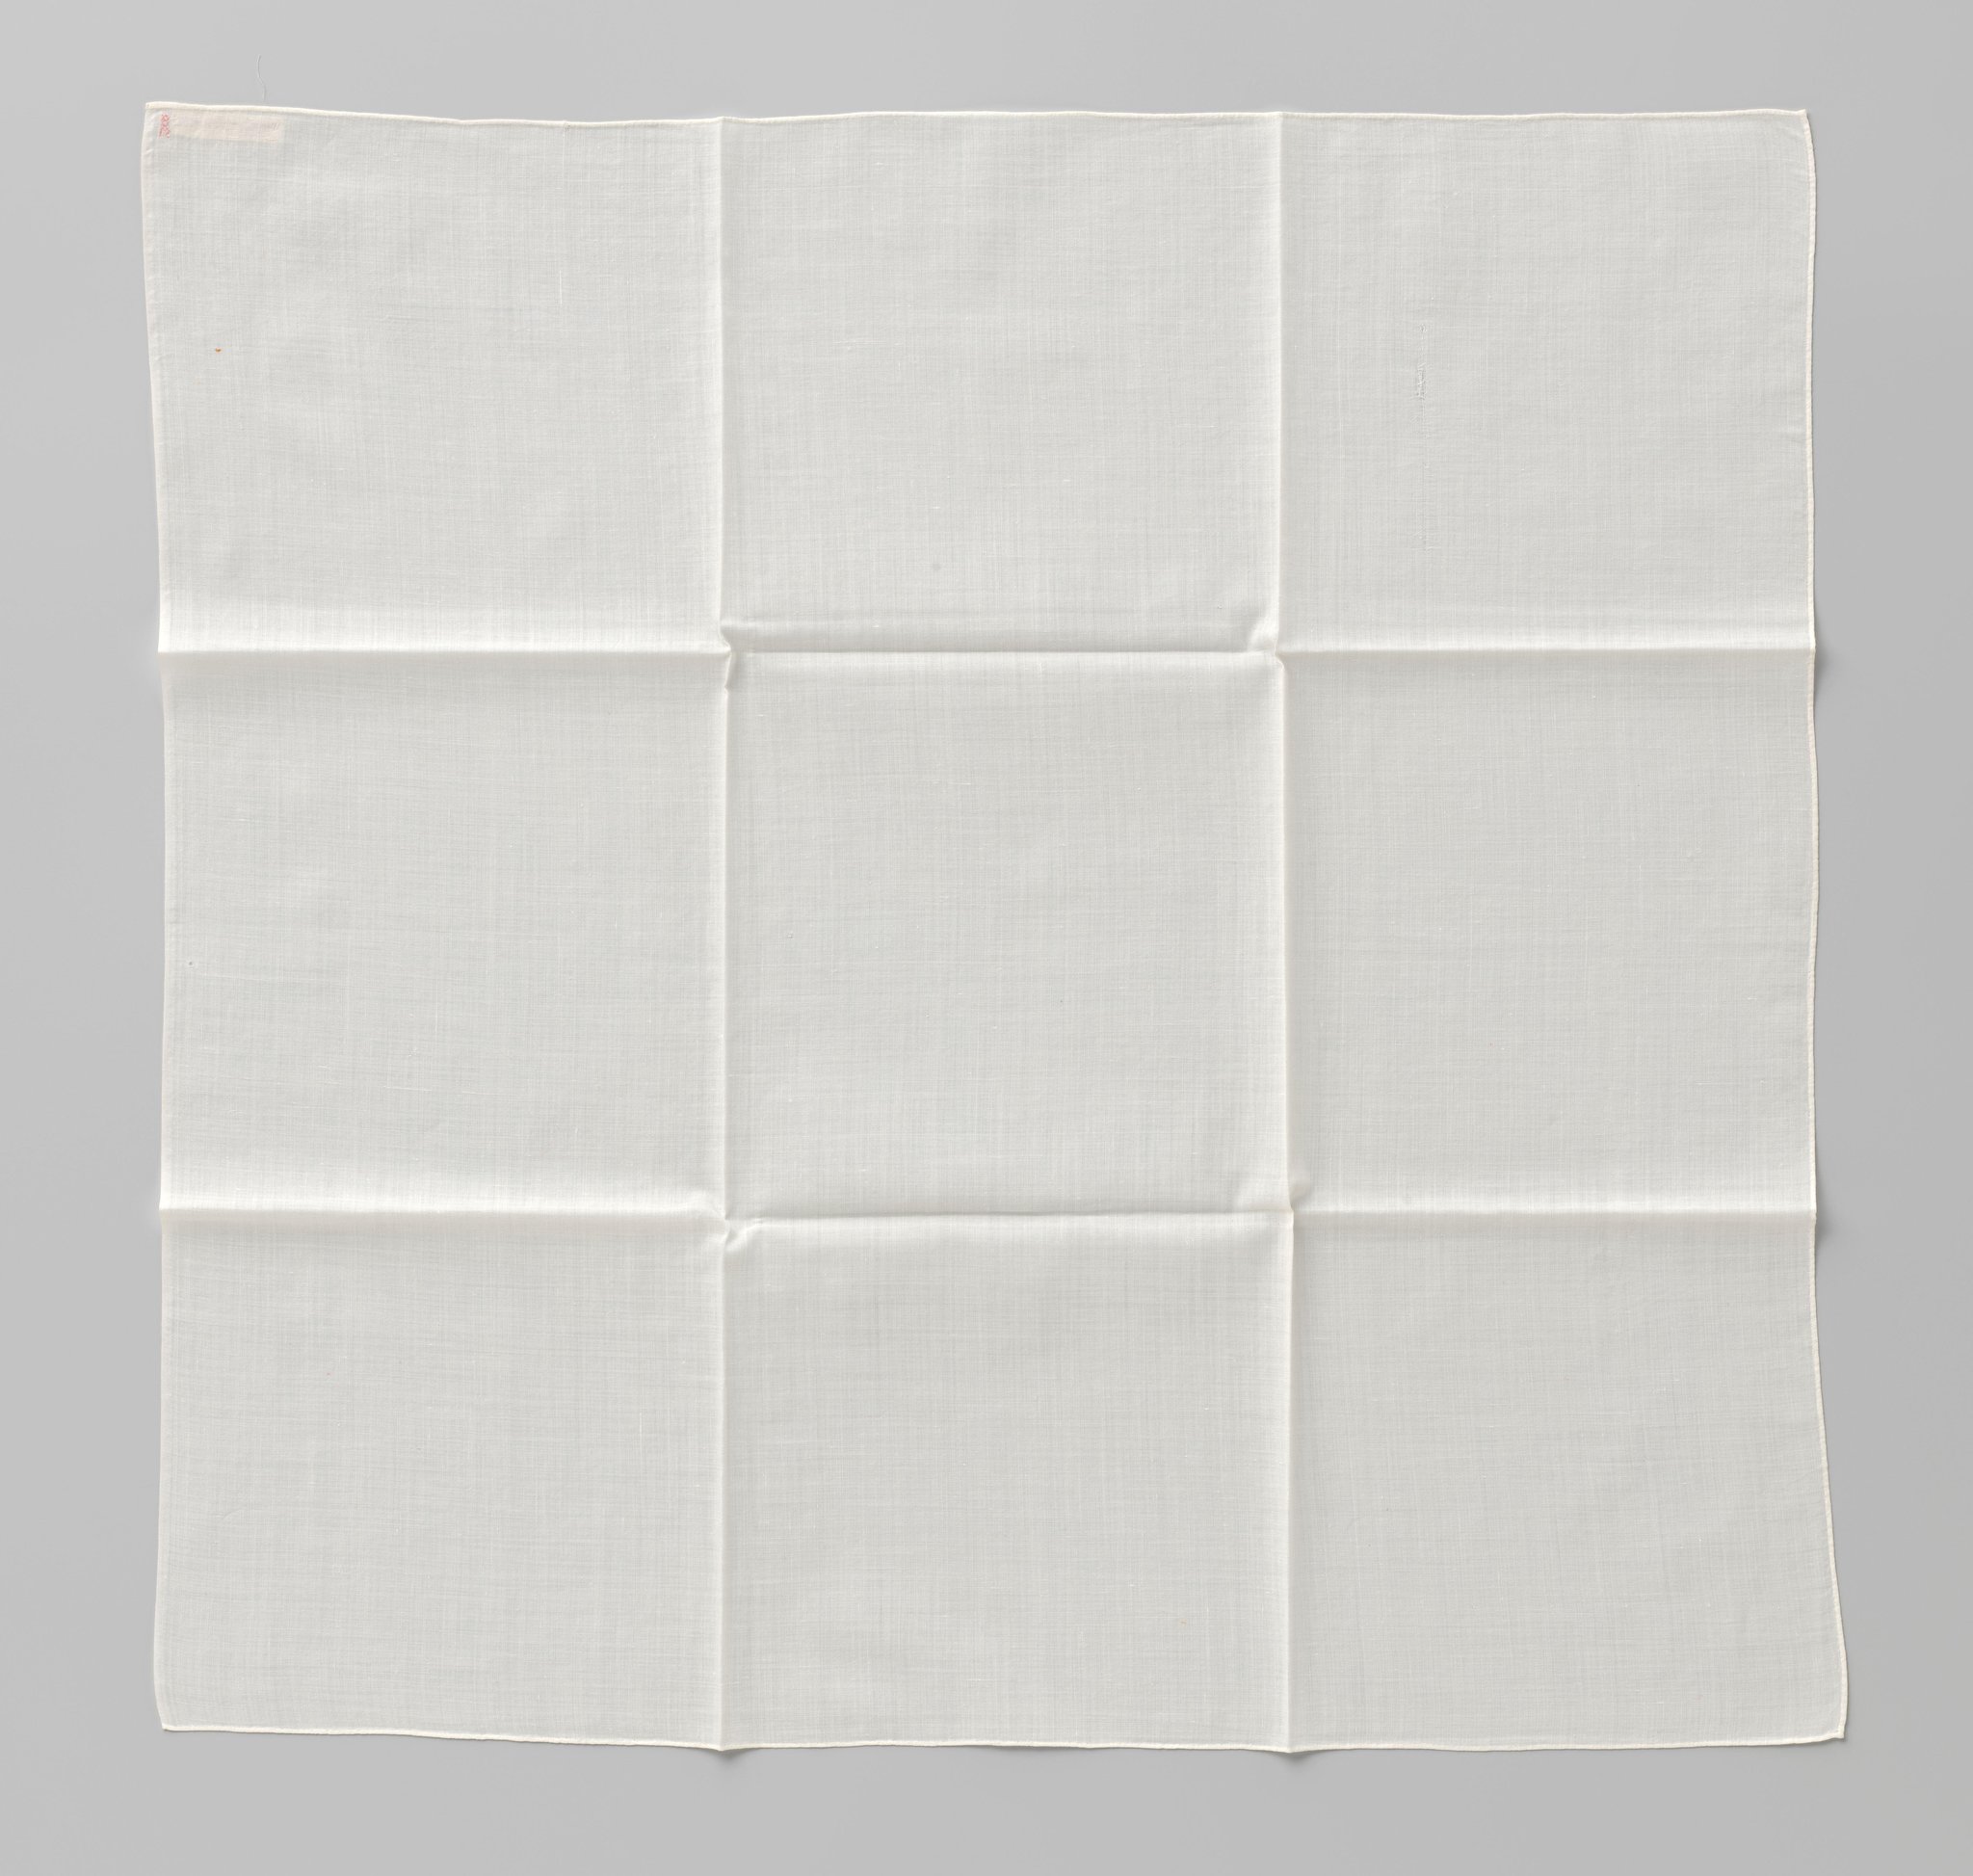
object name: womenswear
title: Vierkante fichu van fijne katoen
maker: Anonymous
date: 1850-1880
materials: cotton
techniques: cross stitching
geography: amsterdam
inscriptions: initials: ‘B // 12’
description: Vierkante fichu van fijne katoen (?), gemerkt in rode kruissteek 'B / 12' (Bosch Reitz, C.I. Bosch Reitz-Teding van Berkhout).